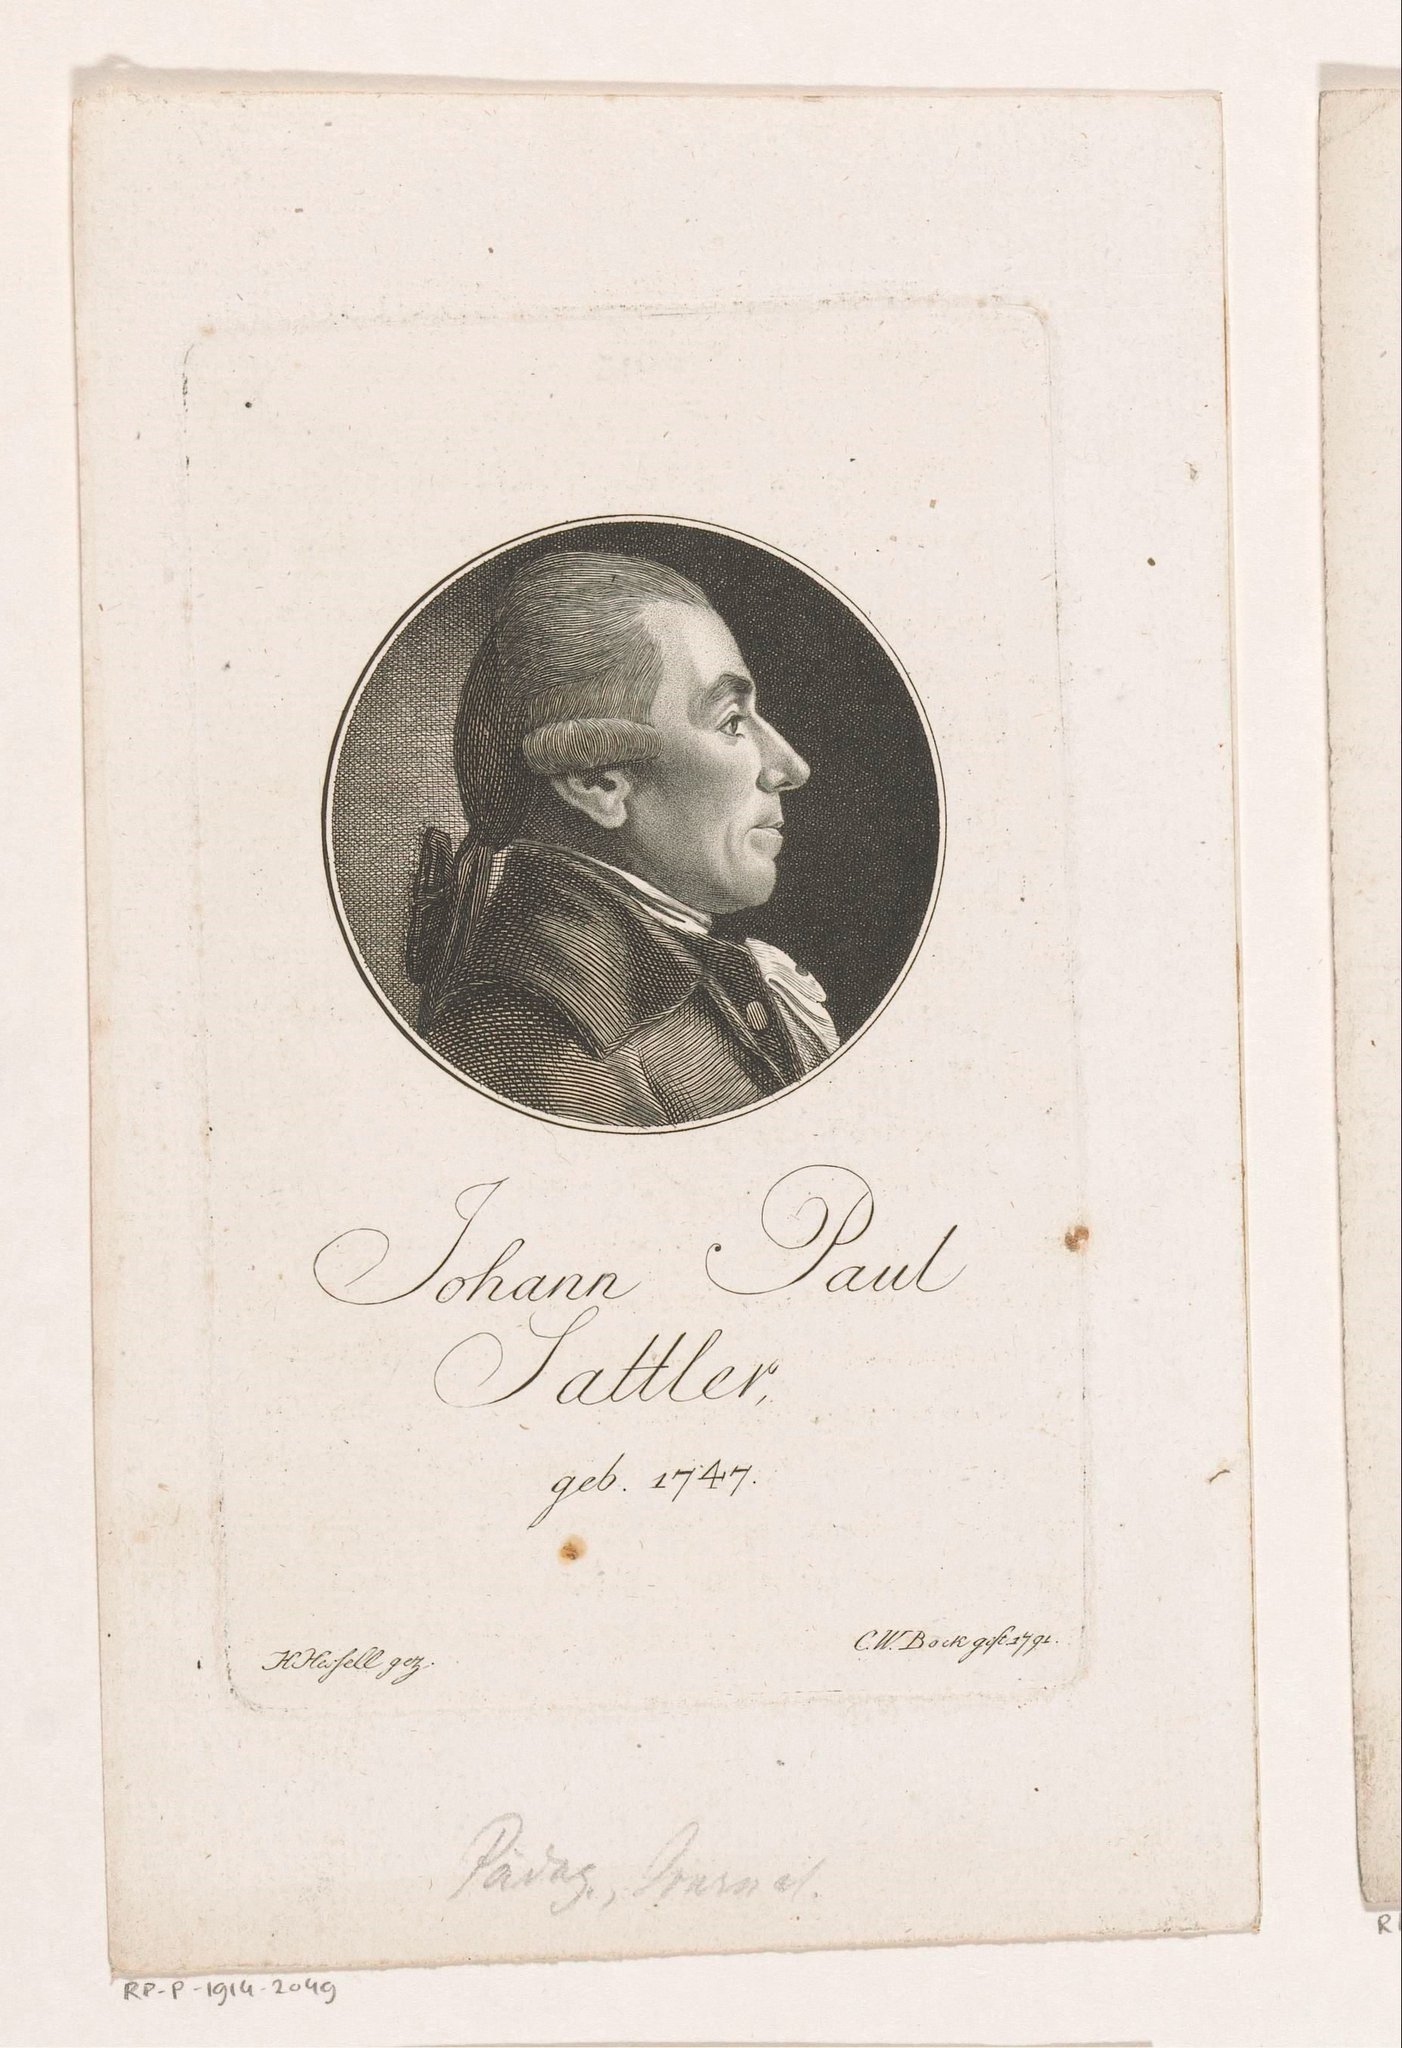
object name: print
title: Portret van Johann Paul Sattler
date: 1791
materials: paper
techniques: engraving, etching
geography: nuremberg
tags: historical persons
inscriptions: collector's mark: Lugt 2228